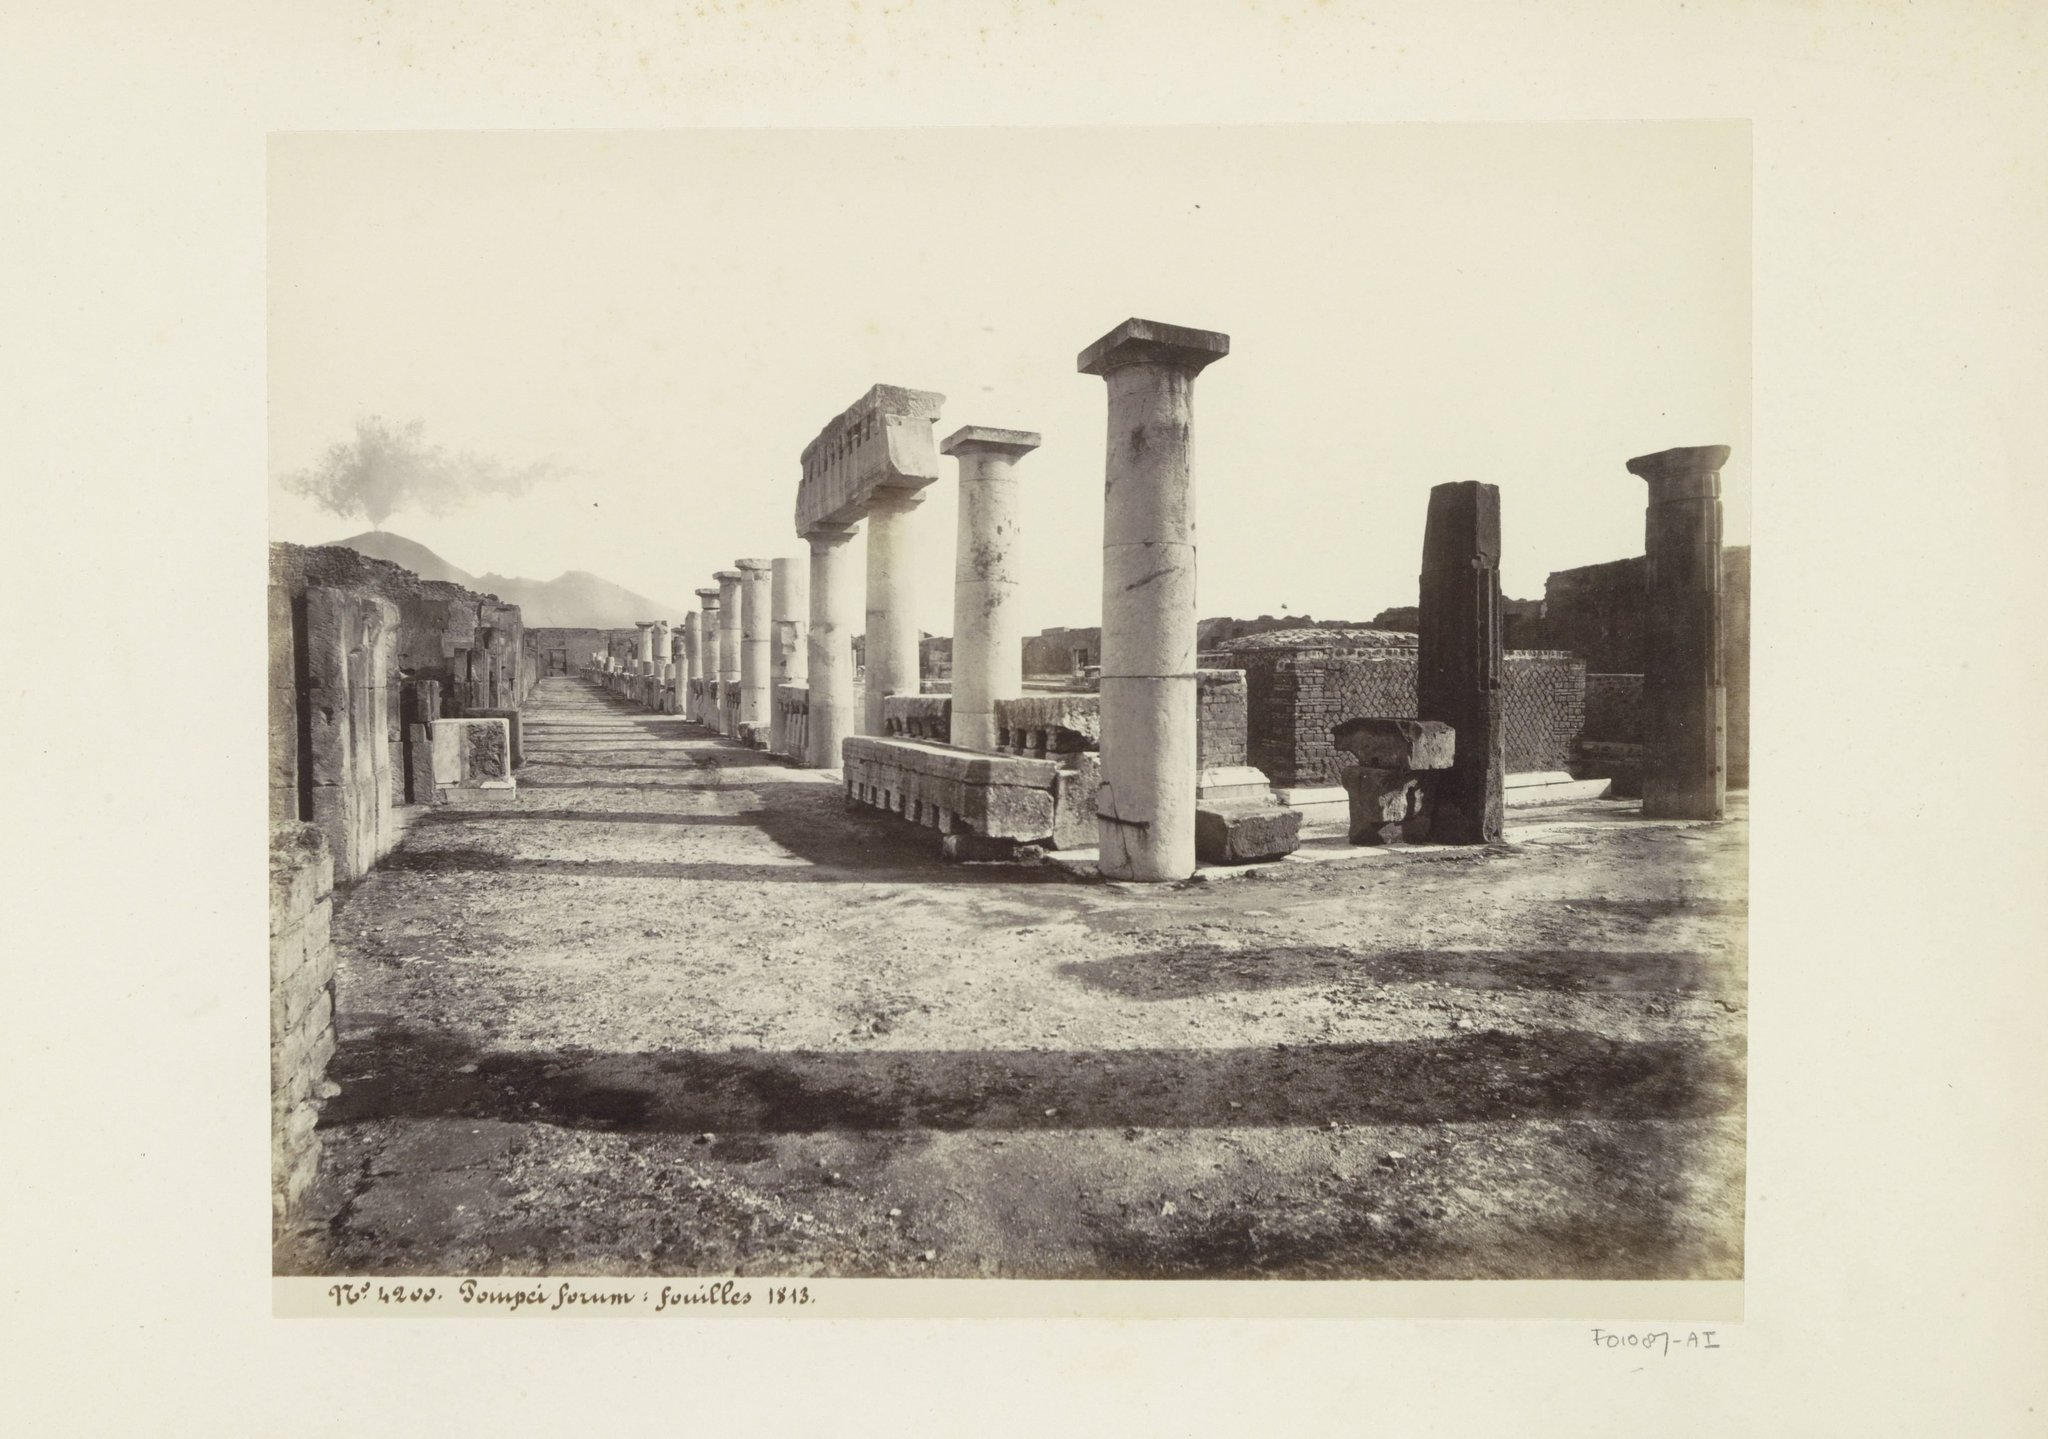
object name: photograph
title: Restanten van gebouwen in Pompeï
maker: Anonymous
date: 1865-1875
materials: paper, photographic support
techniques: albumen print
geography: pompeii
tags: column, pillar ~ architecture, excavation ~ archaeology, pompeii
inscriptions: negative number: ‘4200’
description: Onderdeel van Reisalbum met foto's van bezienswaardigheden in Napels en omgeving.